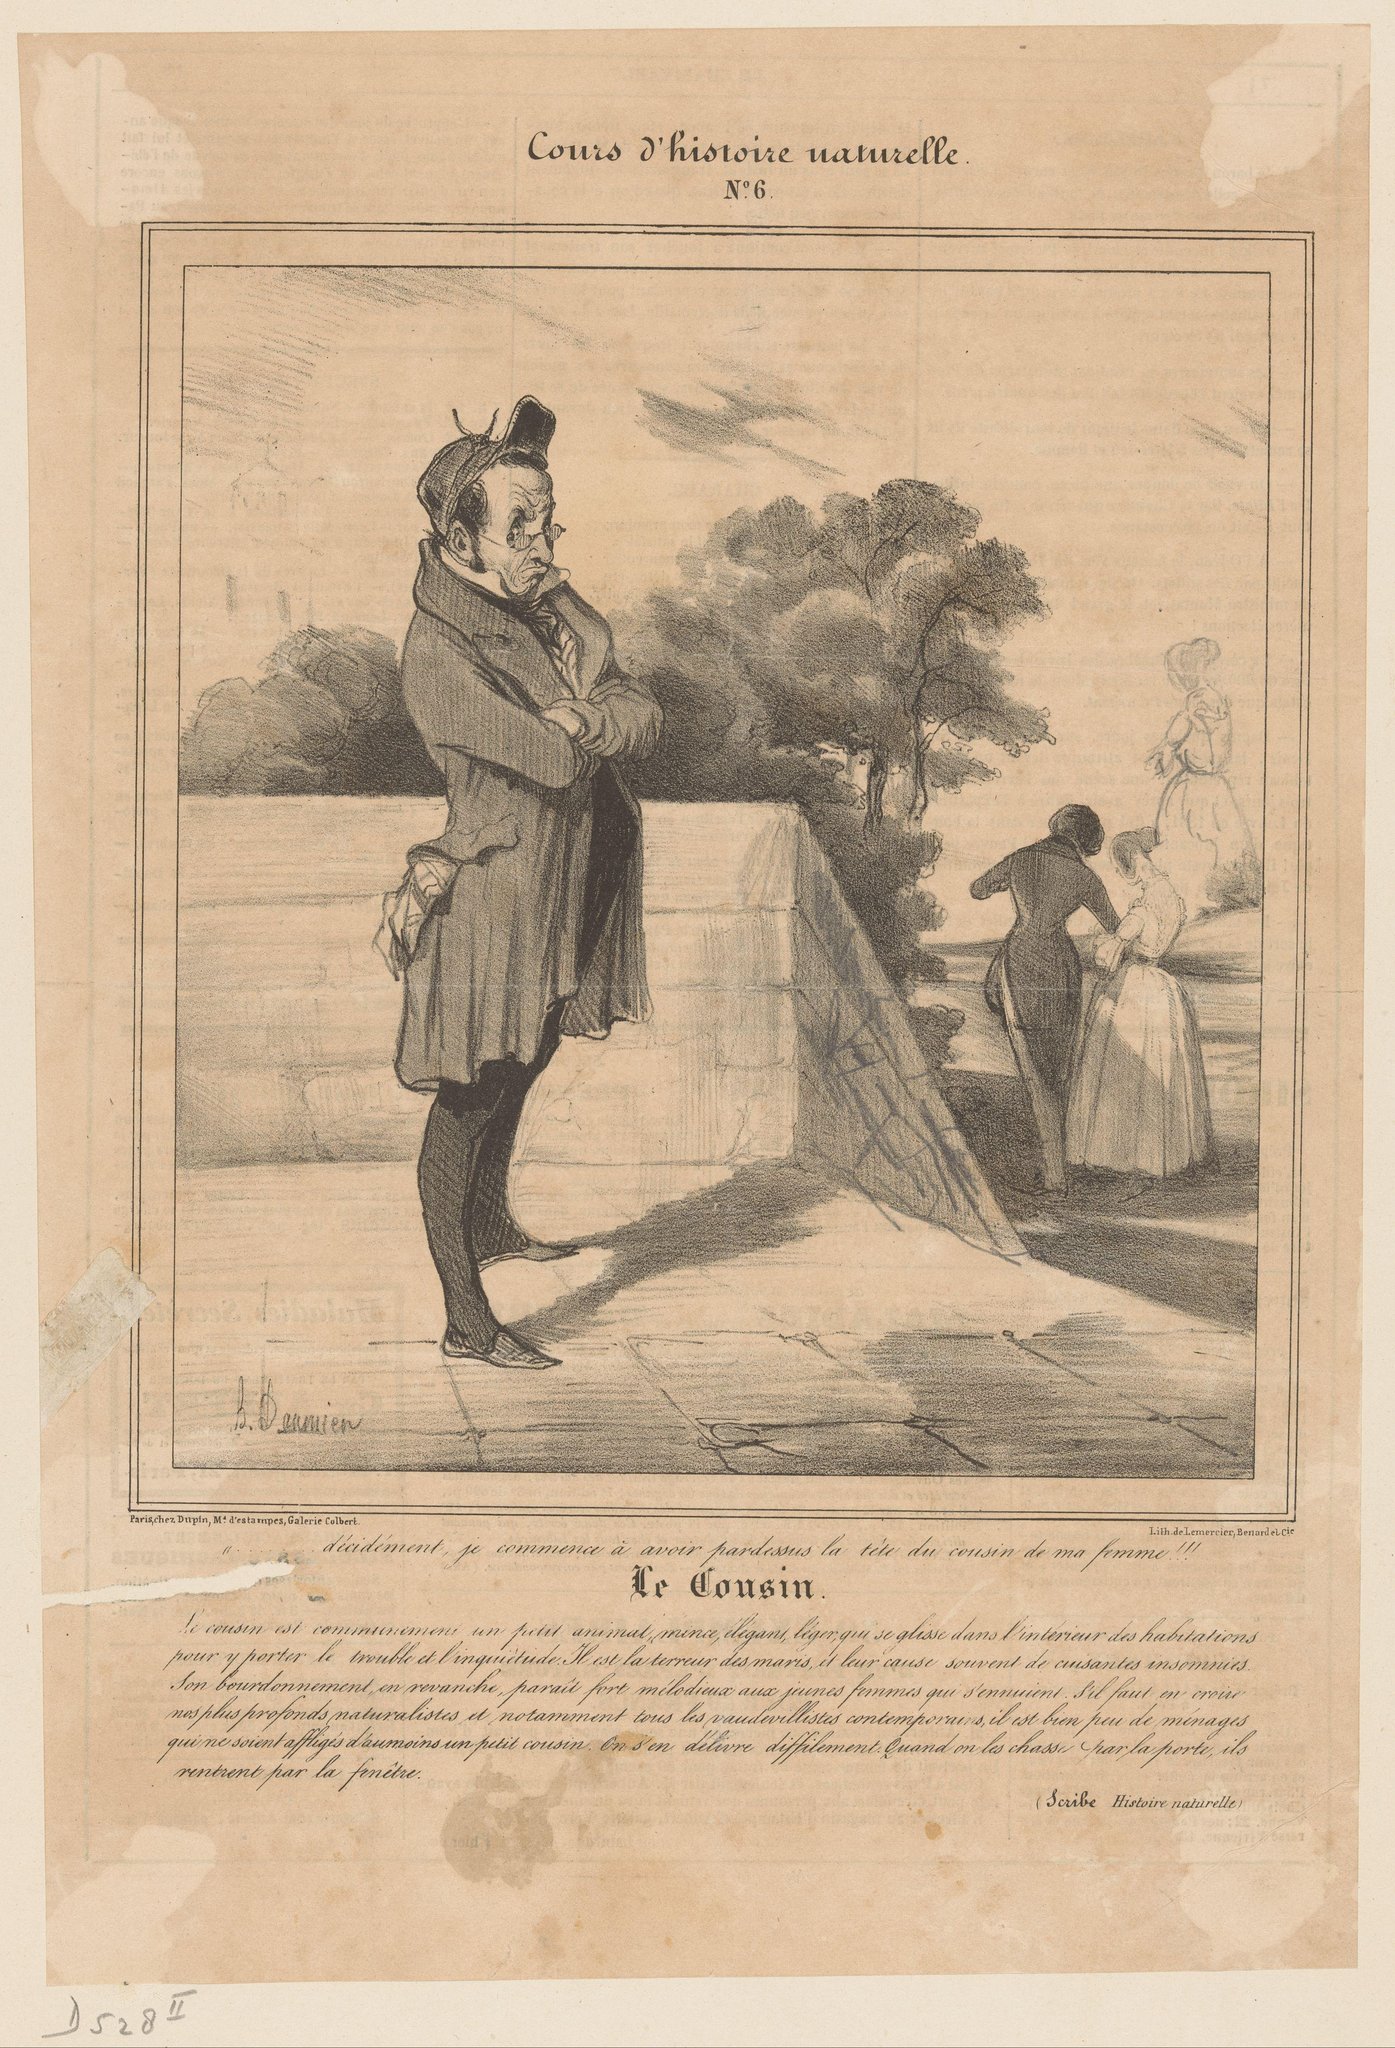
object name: cartoon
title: Cours d'histoire naturelle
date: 1837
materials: paper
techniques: letterpress printing, lithograph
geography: paris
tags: caricatures (human types), cousins (third degree family relationships), satire on marriage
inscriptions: collector's mark: Lugt 2228a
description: Prent mogelijk uit: Le Charivari, 7 december 1837.